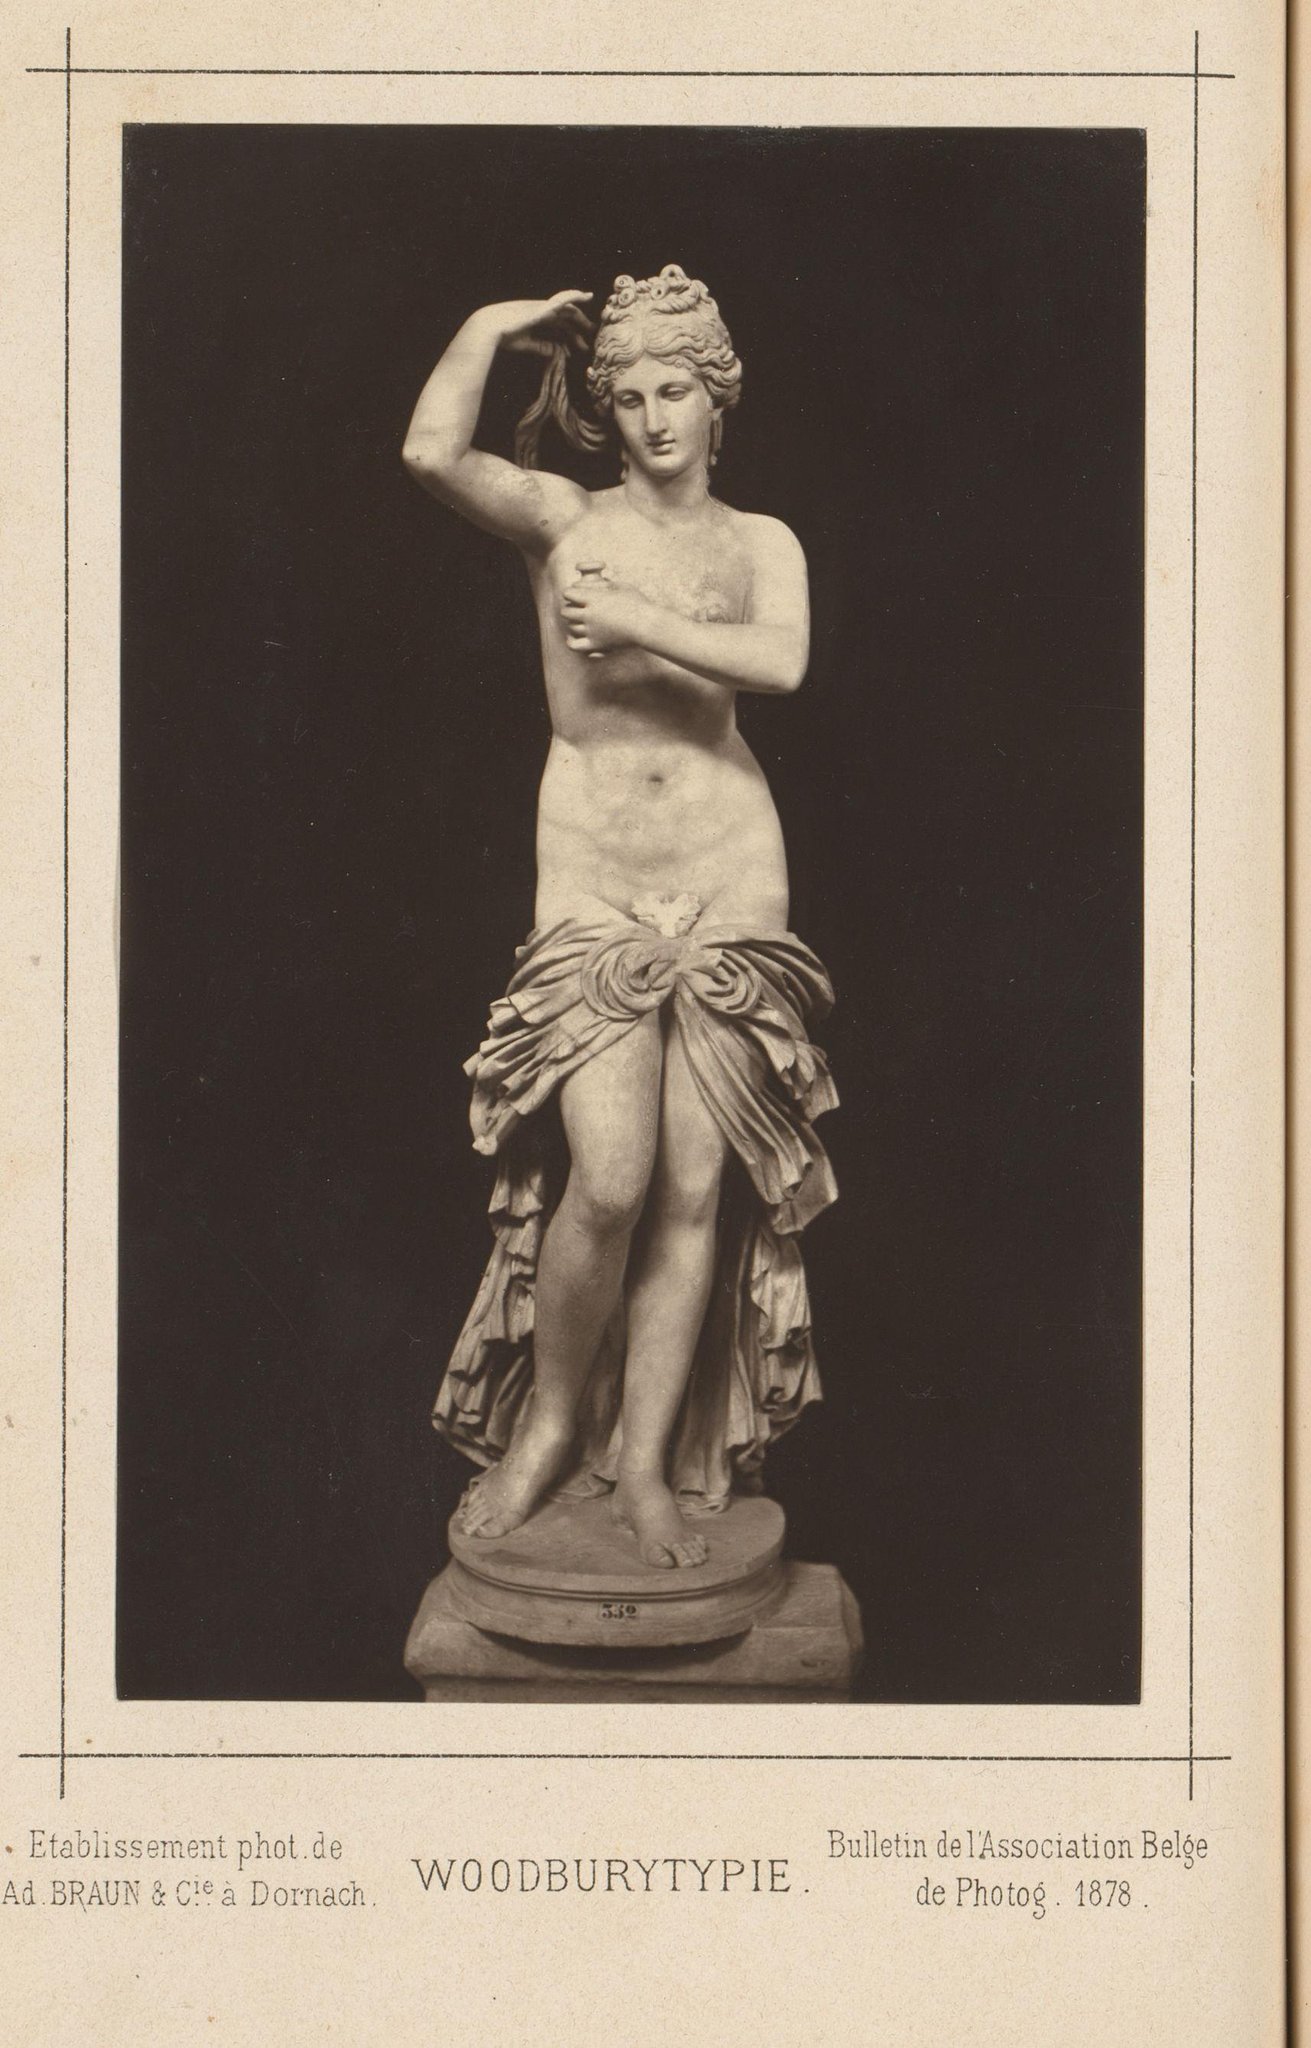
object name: page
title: Sculptuur van de badende Venus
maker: Anonymous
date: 1873-1878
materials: paper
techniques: woodburytype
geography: dornach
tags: sculpture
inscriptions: inscription: ‘Bulletin de l'Association Belge de Photographie/ Médaillé au concours de 1878.’